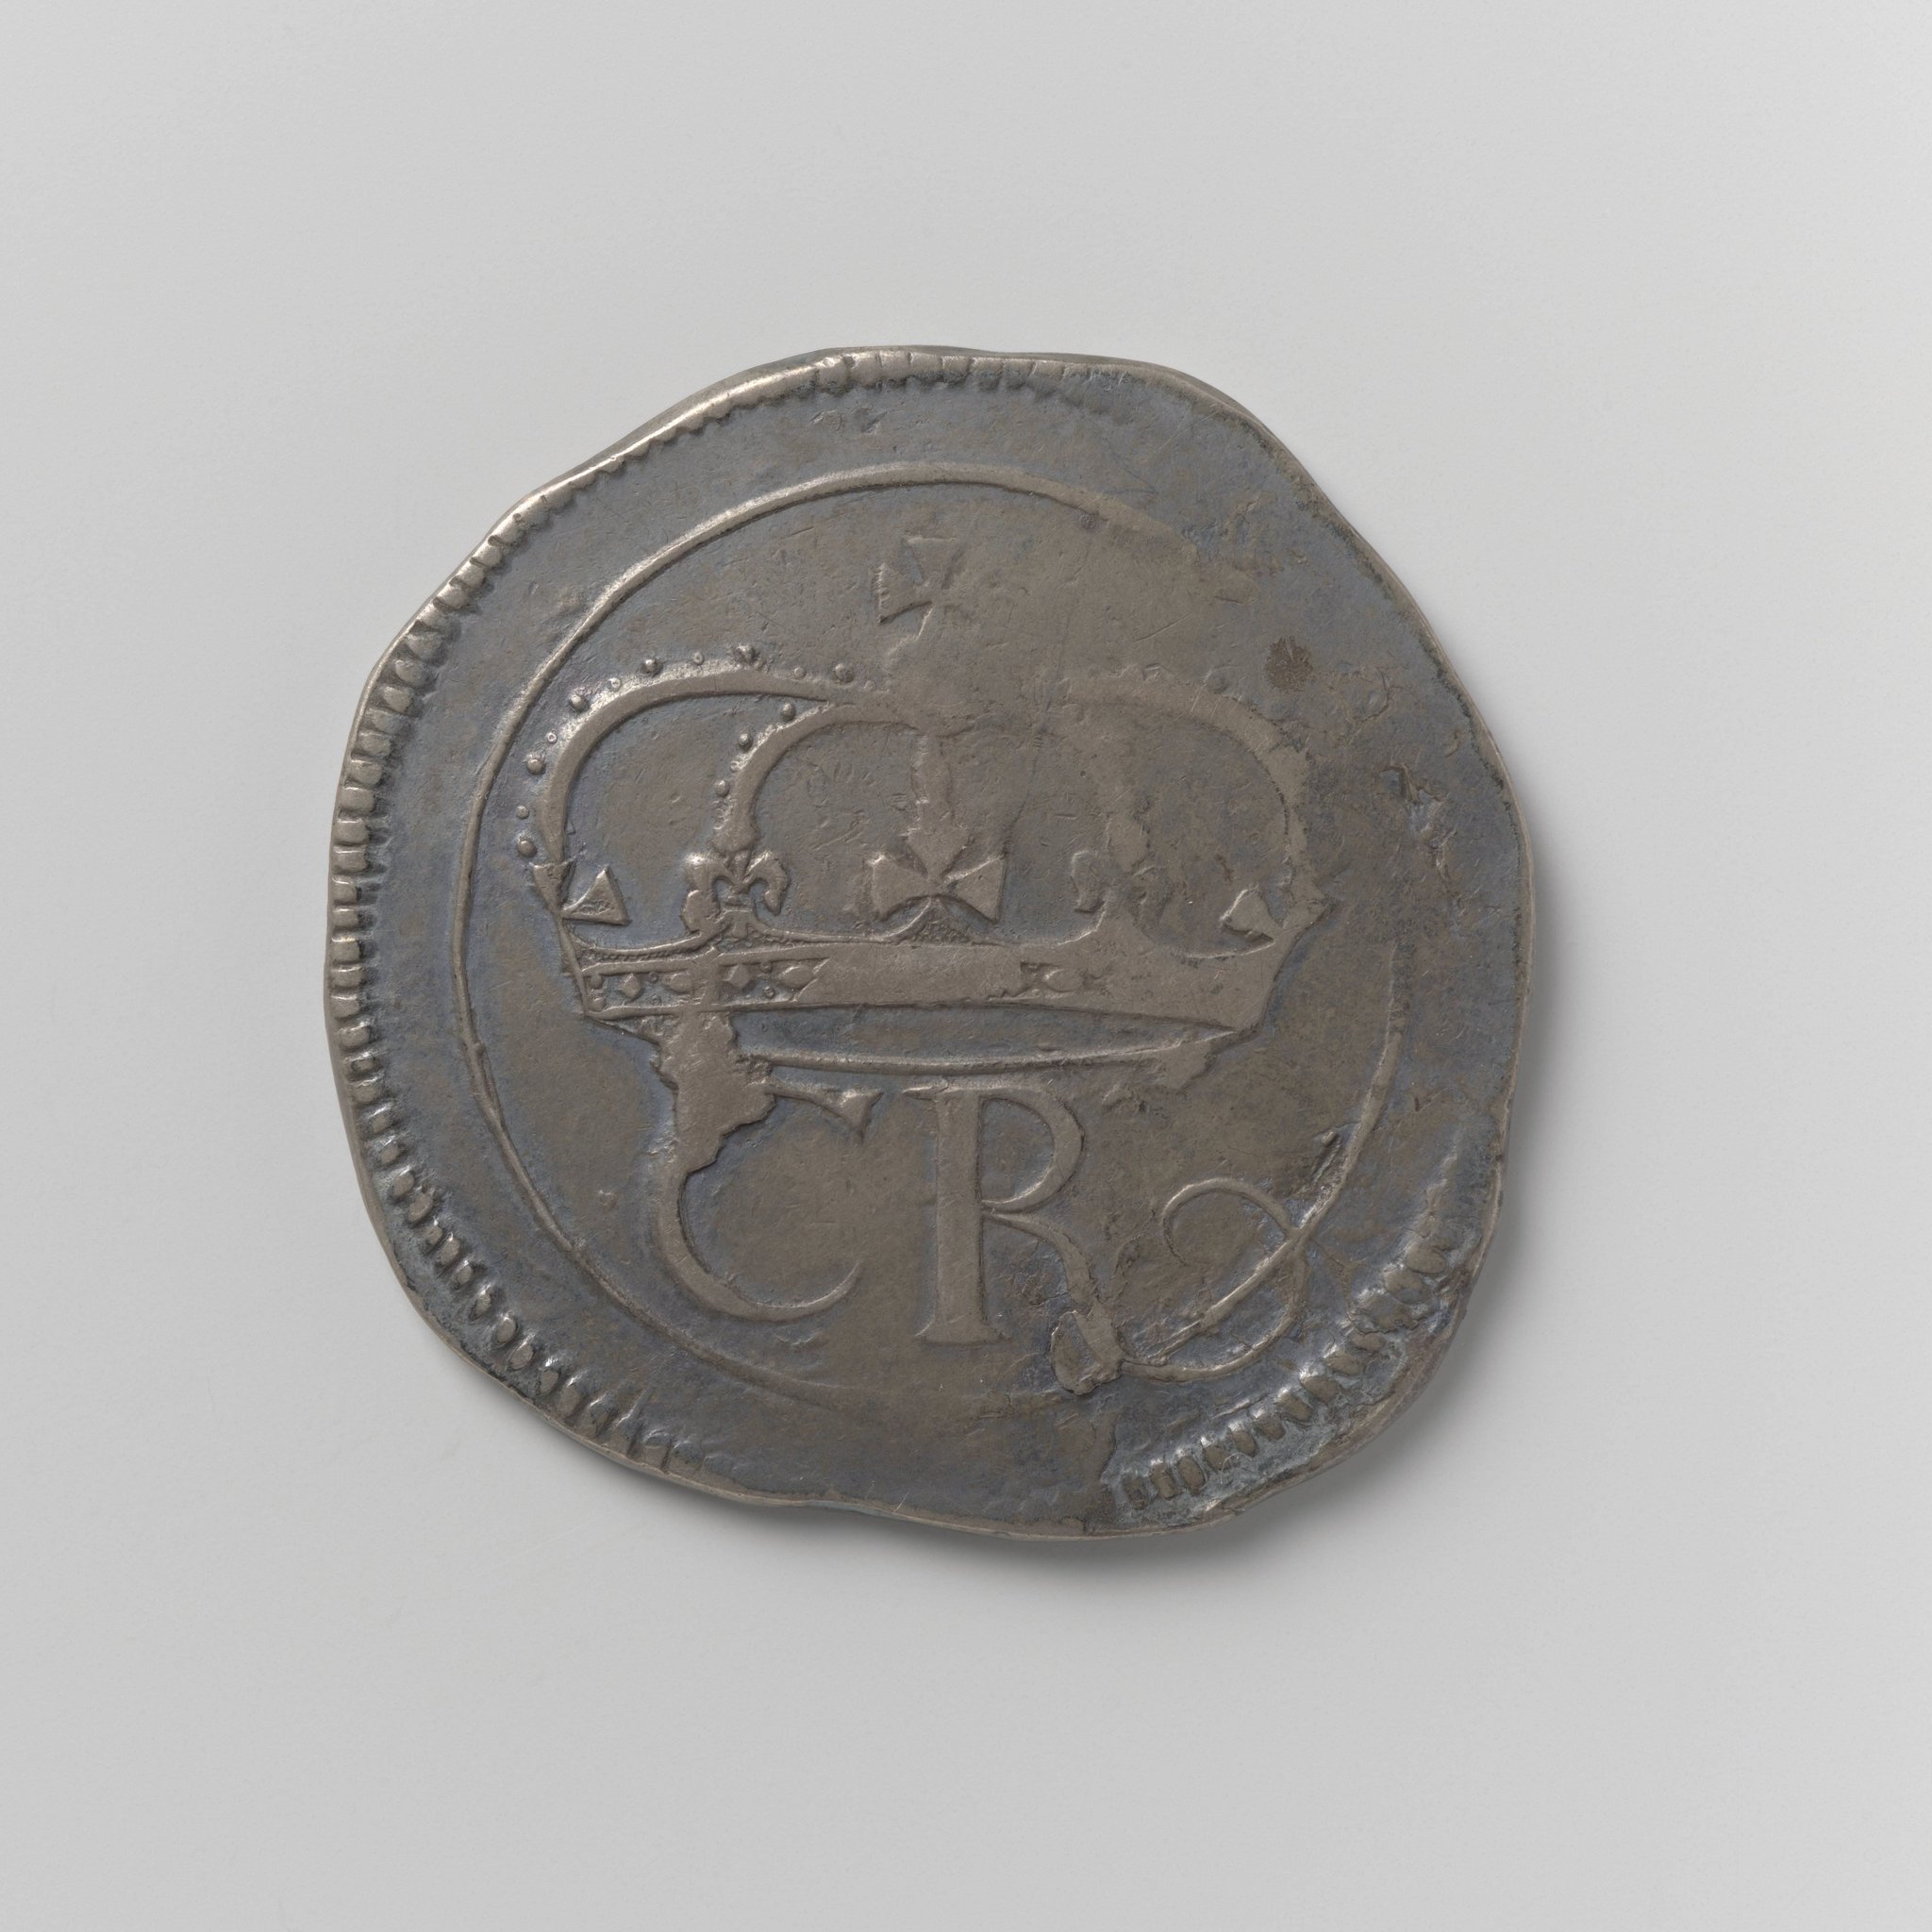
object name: siege coin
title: Vijf shilling, noodmunt van Karel I, koning van Engeland te Ormond geslagen van het door de ingezetenen opgebrachte zilver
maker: Anonymous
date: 1643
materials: silver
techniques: striking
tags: london, karel i (koning van engeland)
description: Bijna ronde zilveren noodmunt. Voorzijde: kroon boven letters C en R binnen parelrand. Keerzijde: waardeaanduiding (vijf shilling): Romeins cijfer V onder letter S binnen parelrand. Crown.